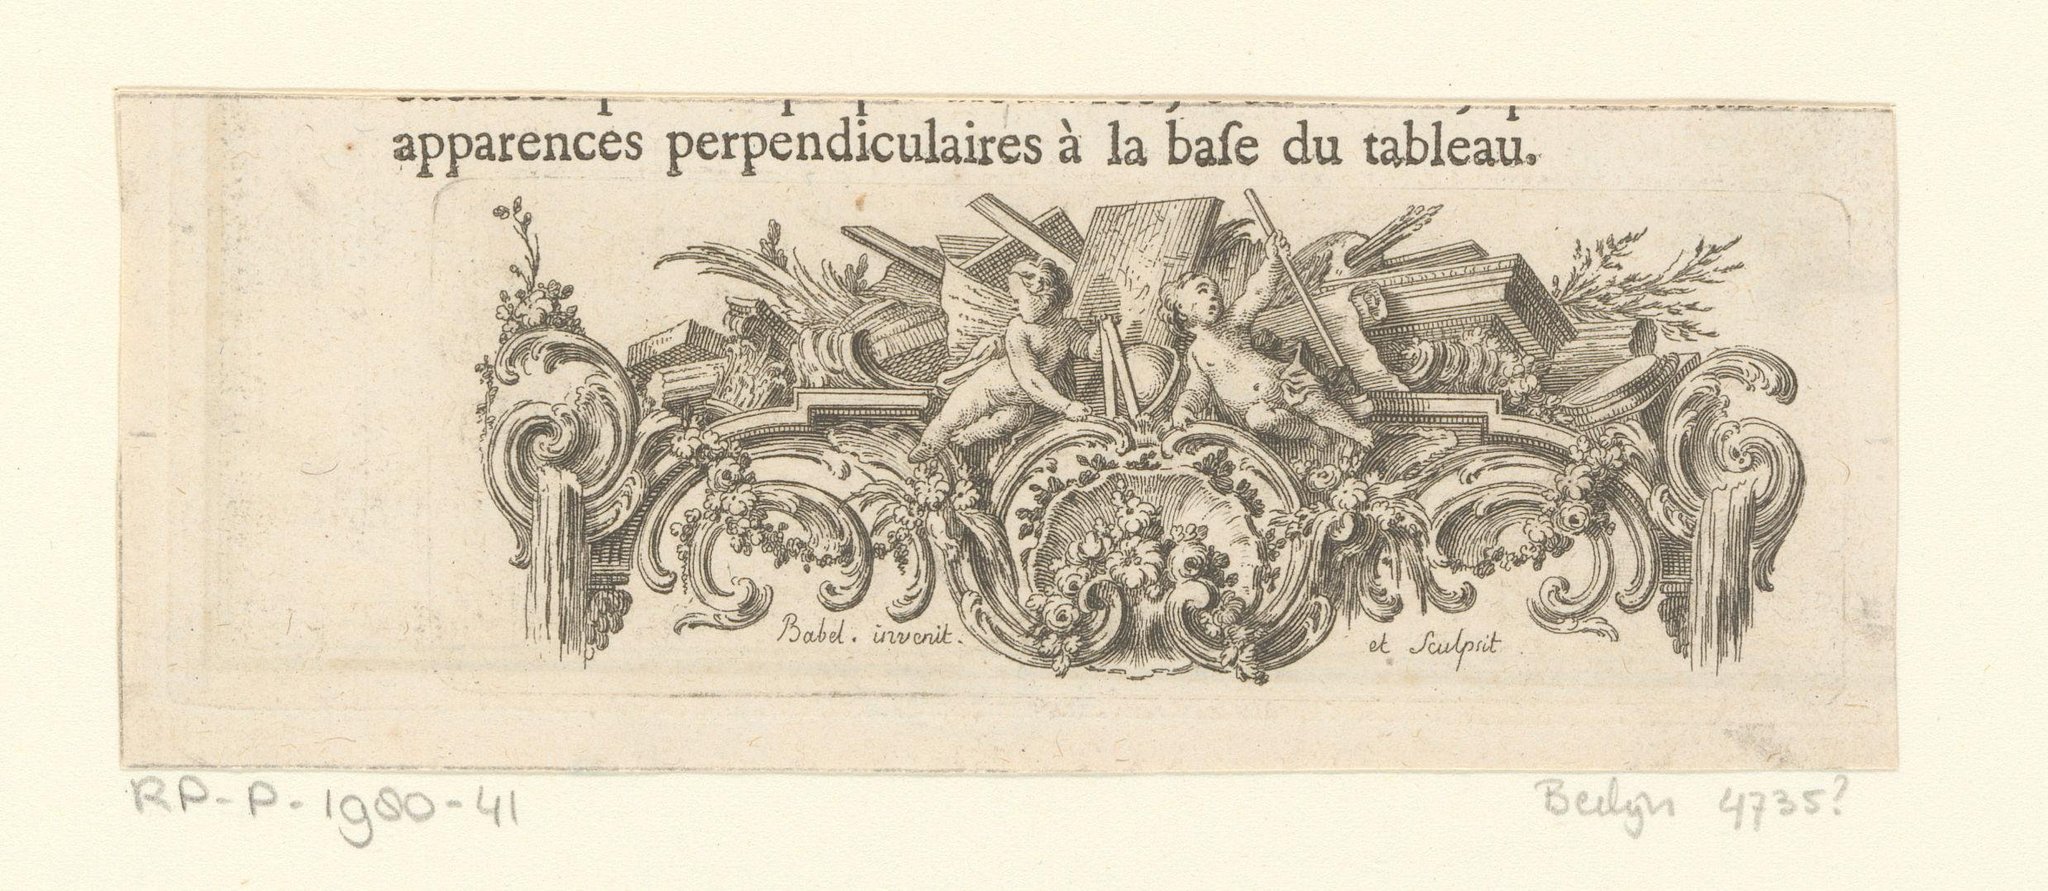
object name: ornament print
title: Vignet met putti met schildersattributen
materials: paper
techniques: etching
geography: paris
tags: tools, implements of painter, ornament ~ cartouche, cupids: 'amores', 'amoretti', 'putti'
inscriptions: collector's mark: Lugt 2228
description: Pagina 10 uit: Edme-Sébastien. Traité de perspective à l'usage des artistes (...). Parijs: Jombert, Charles Antoine, 1750.